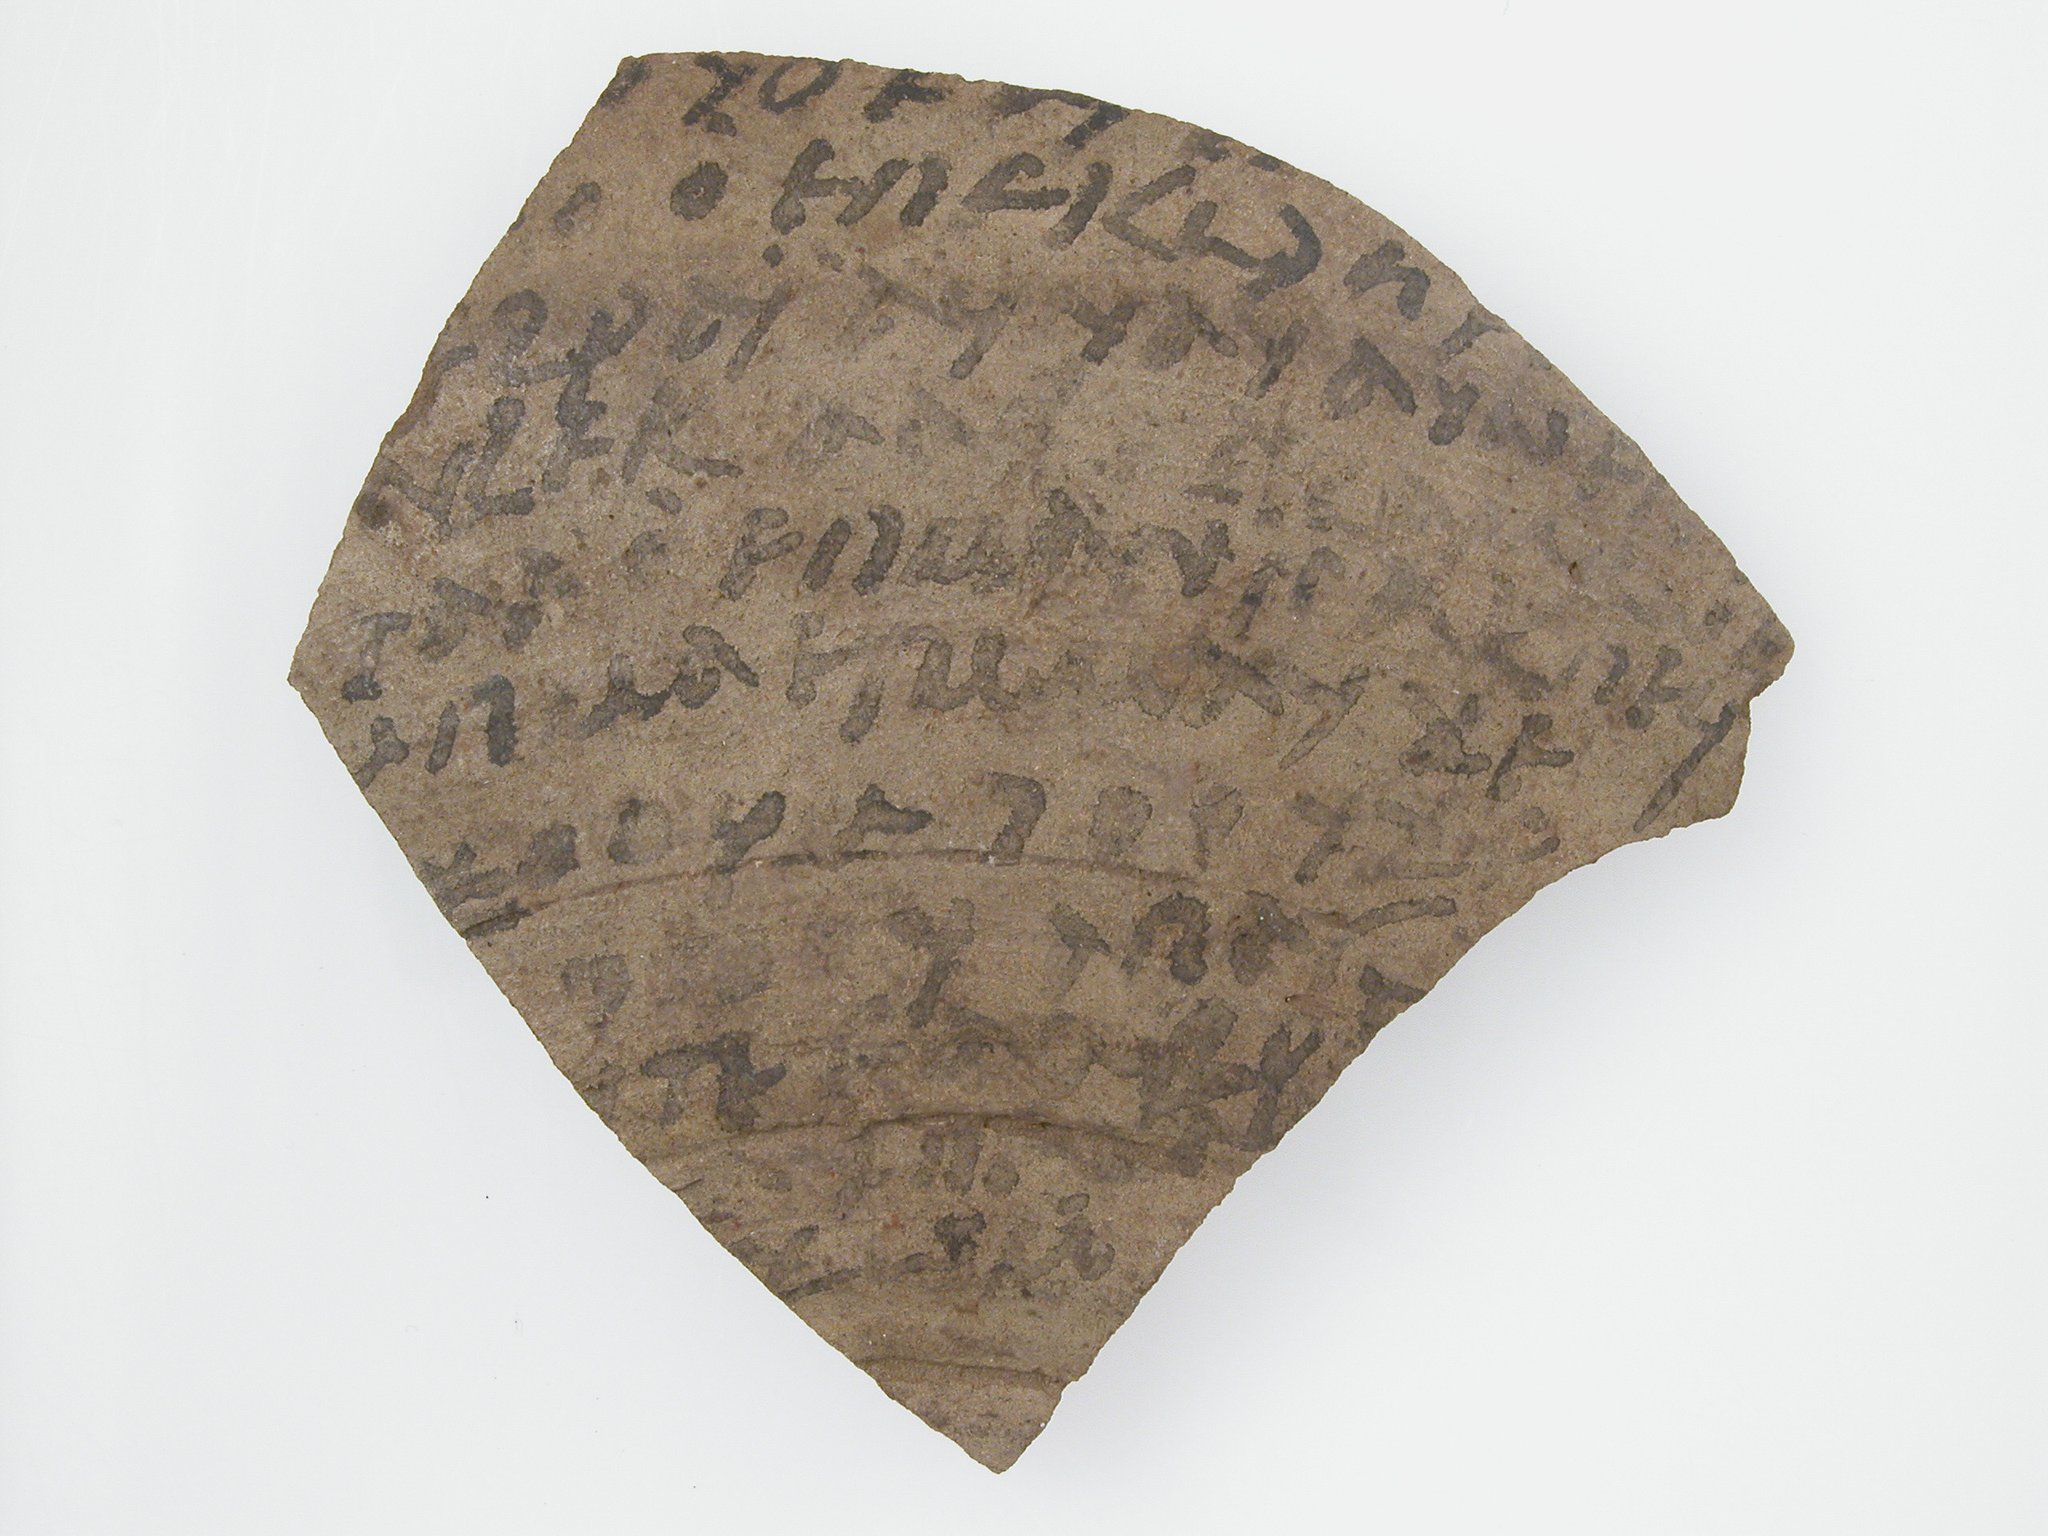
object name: ostrakon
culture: coptic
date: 601-700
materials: ink, pottery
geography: egypt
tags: documents